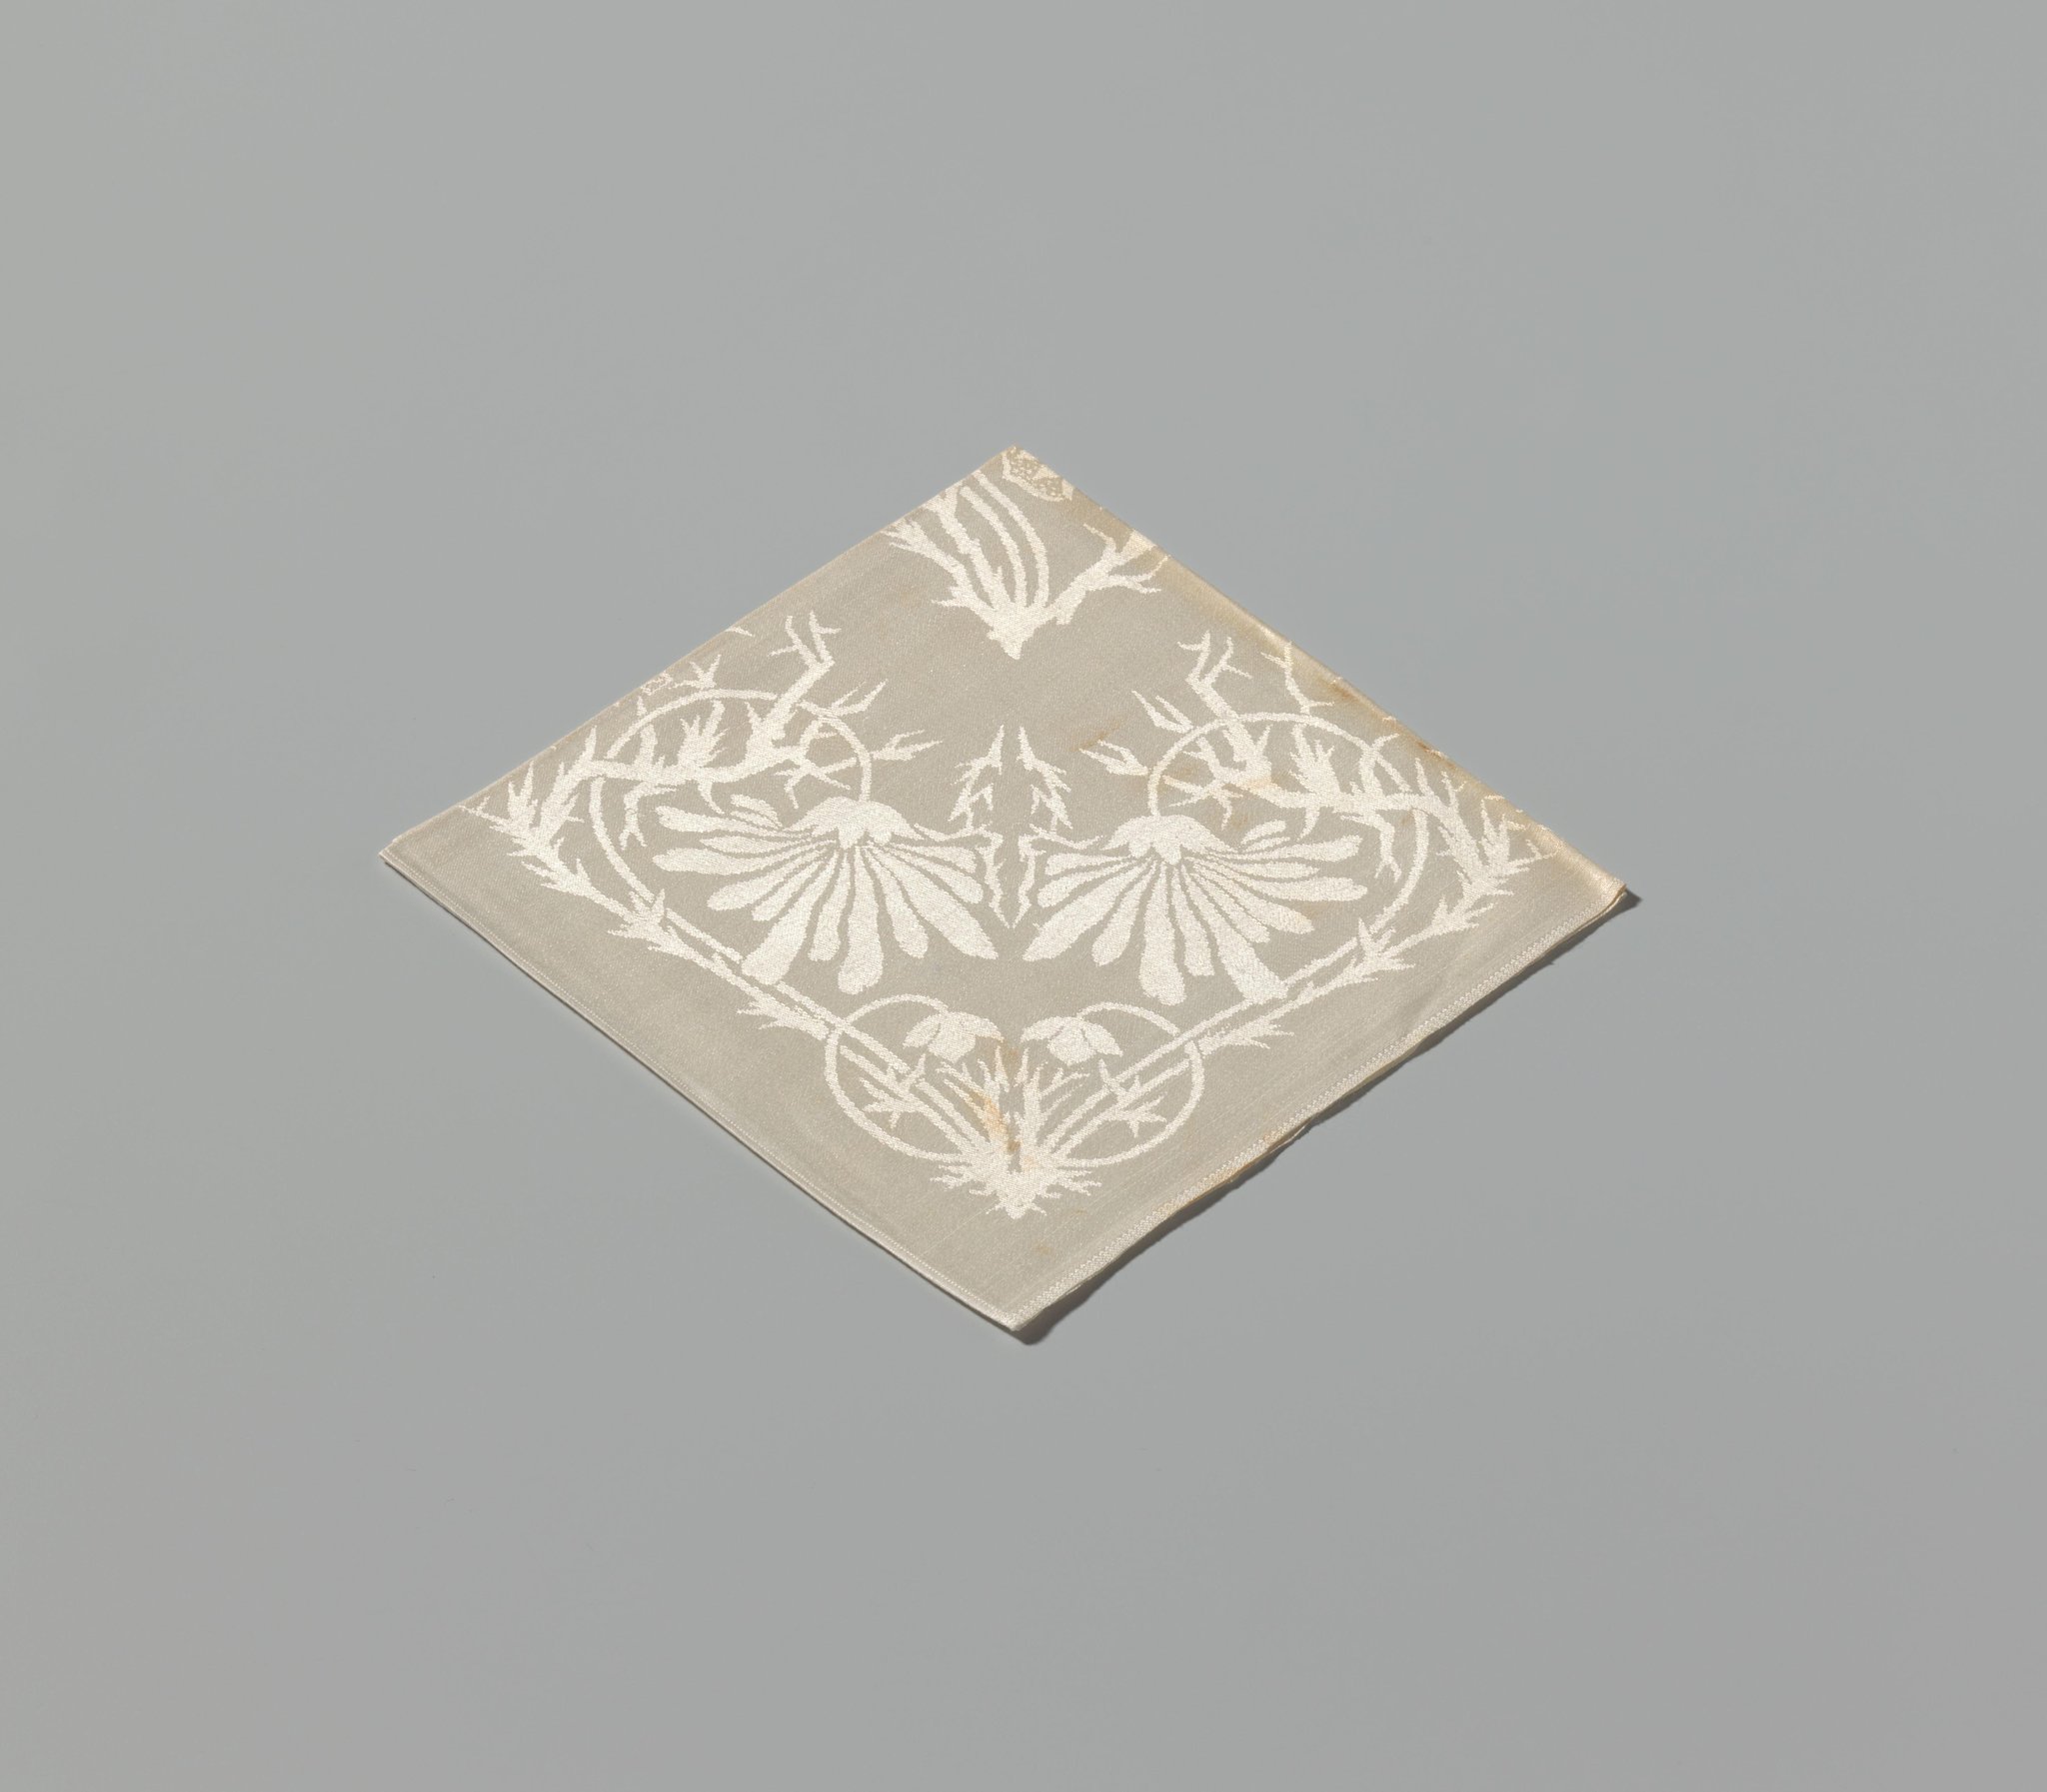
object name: vingerdoek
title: Vingerdoek van linnendamast met dessin Marguerite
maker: cornelis van der sluys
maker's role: print maker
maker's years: 1881-1944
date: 1904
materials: linen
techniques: damask, weave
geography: eindhoven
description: Vingerdoek van linnendamast met een bloempatroon: motief Marguerite, dessin nr. 500. De vingerdoek hoort bij elf vingerdoeken, dertien servetten en een tafellaken.